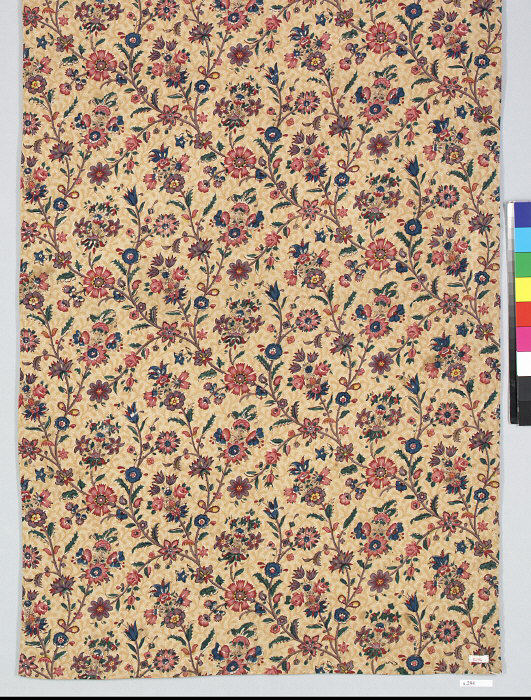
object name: piece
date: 1801-1850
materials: cotton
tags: flowers,leaves